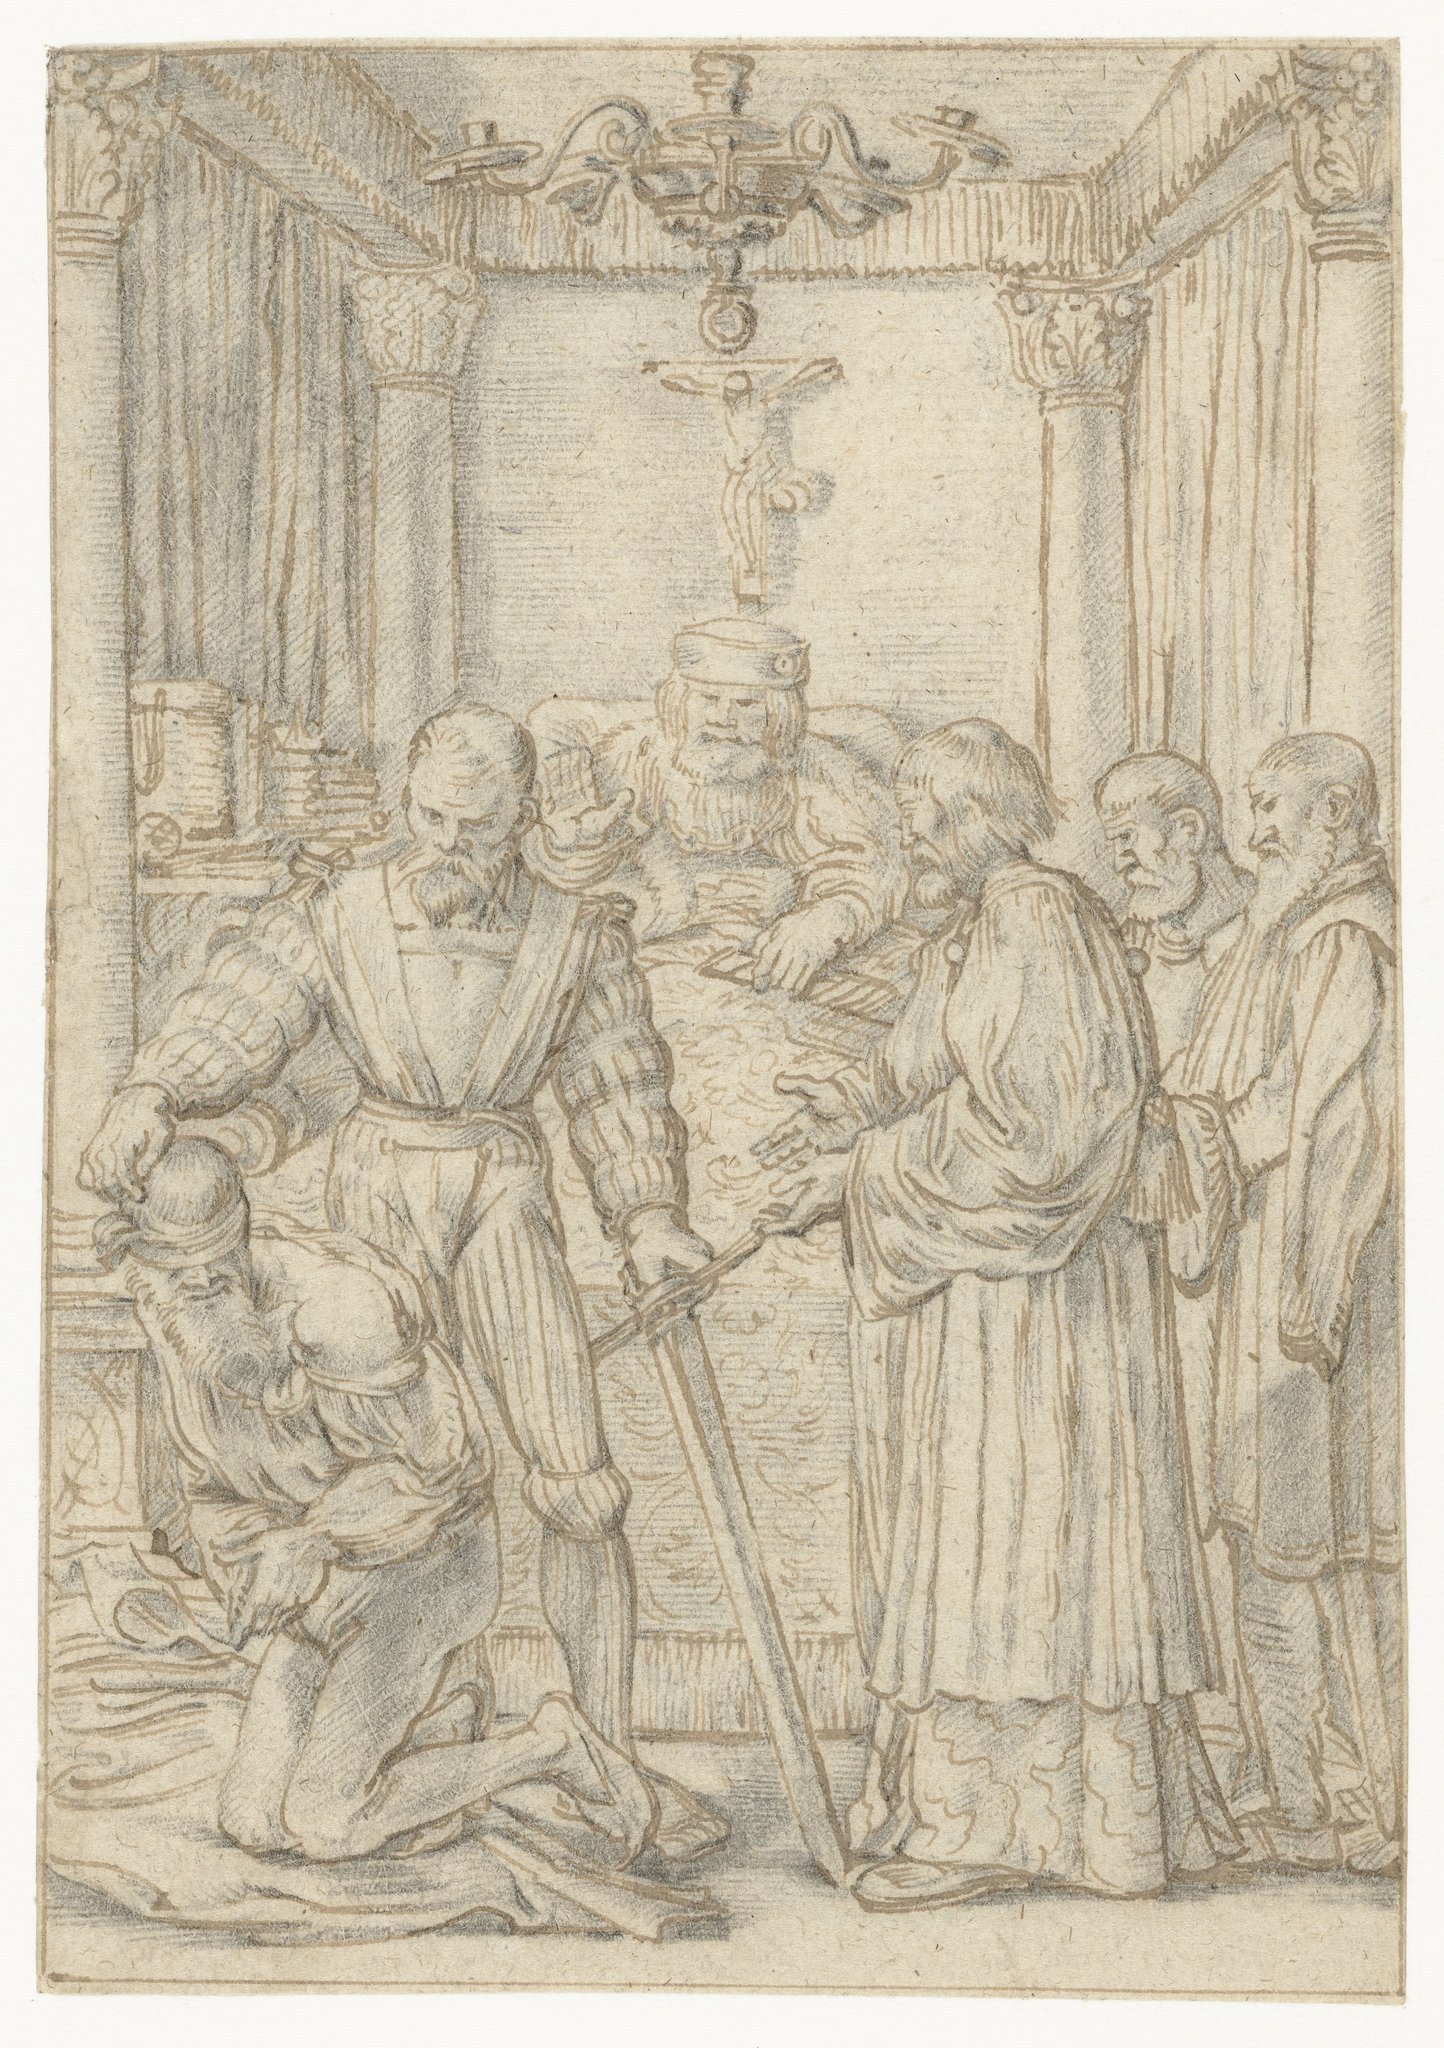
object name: drawing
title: Terechtstelling van de baljuw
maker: willem pietersz buytewech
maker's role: draughtsman, print maker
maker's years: 1592-1624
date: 1618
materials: chalk, ink, paper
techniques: pen